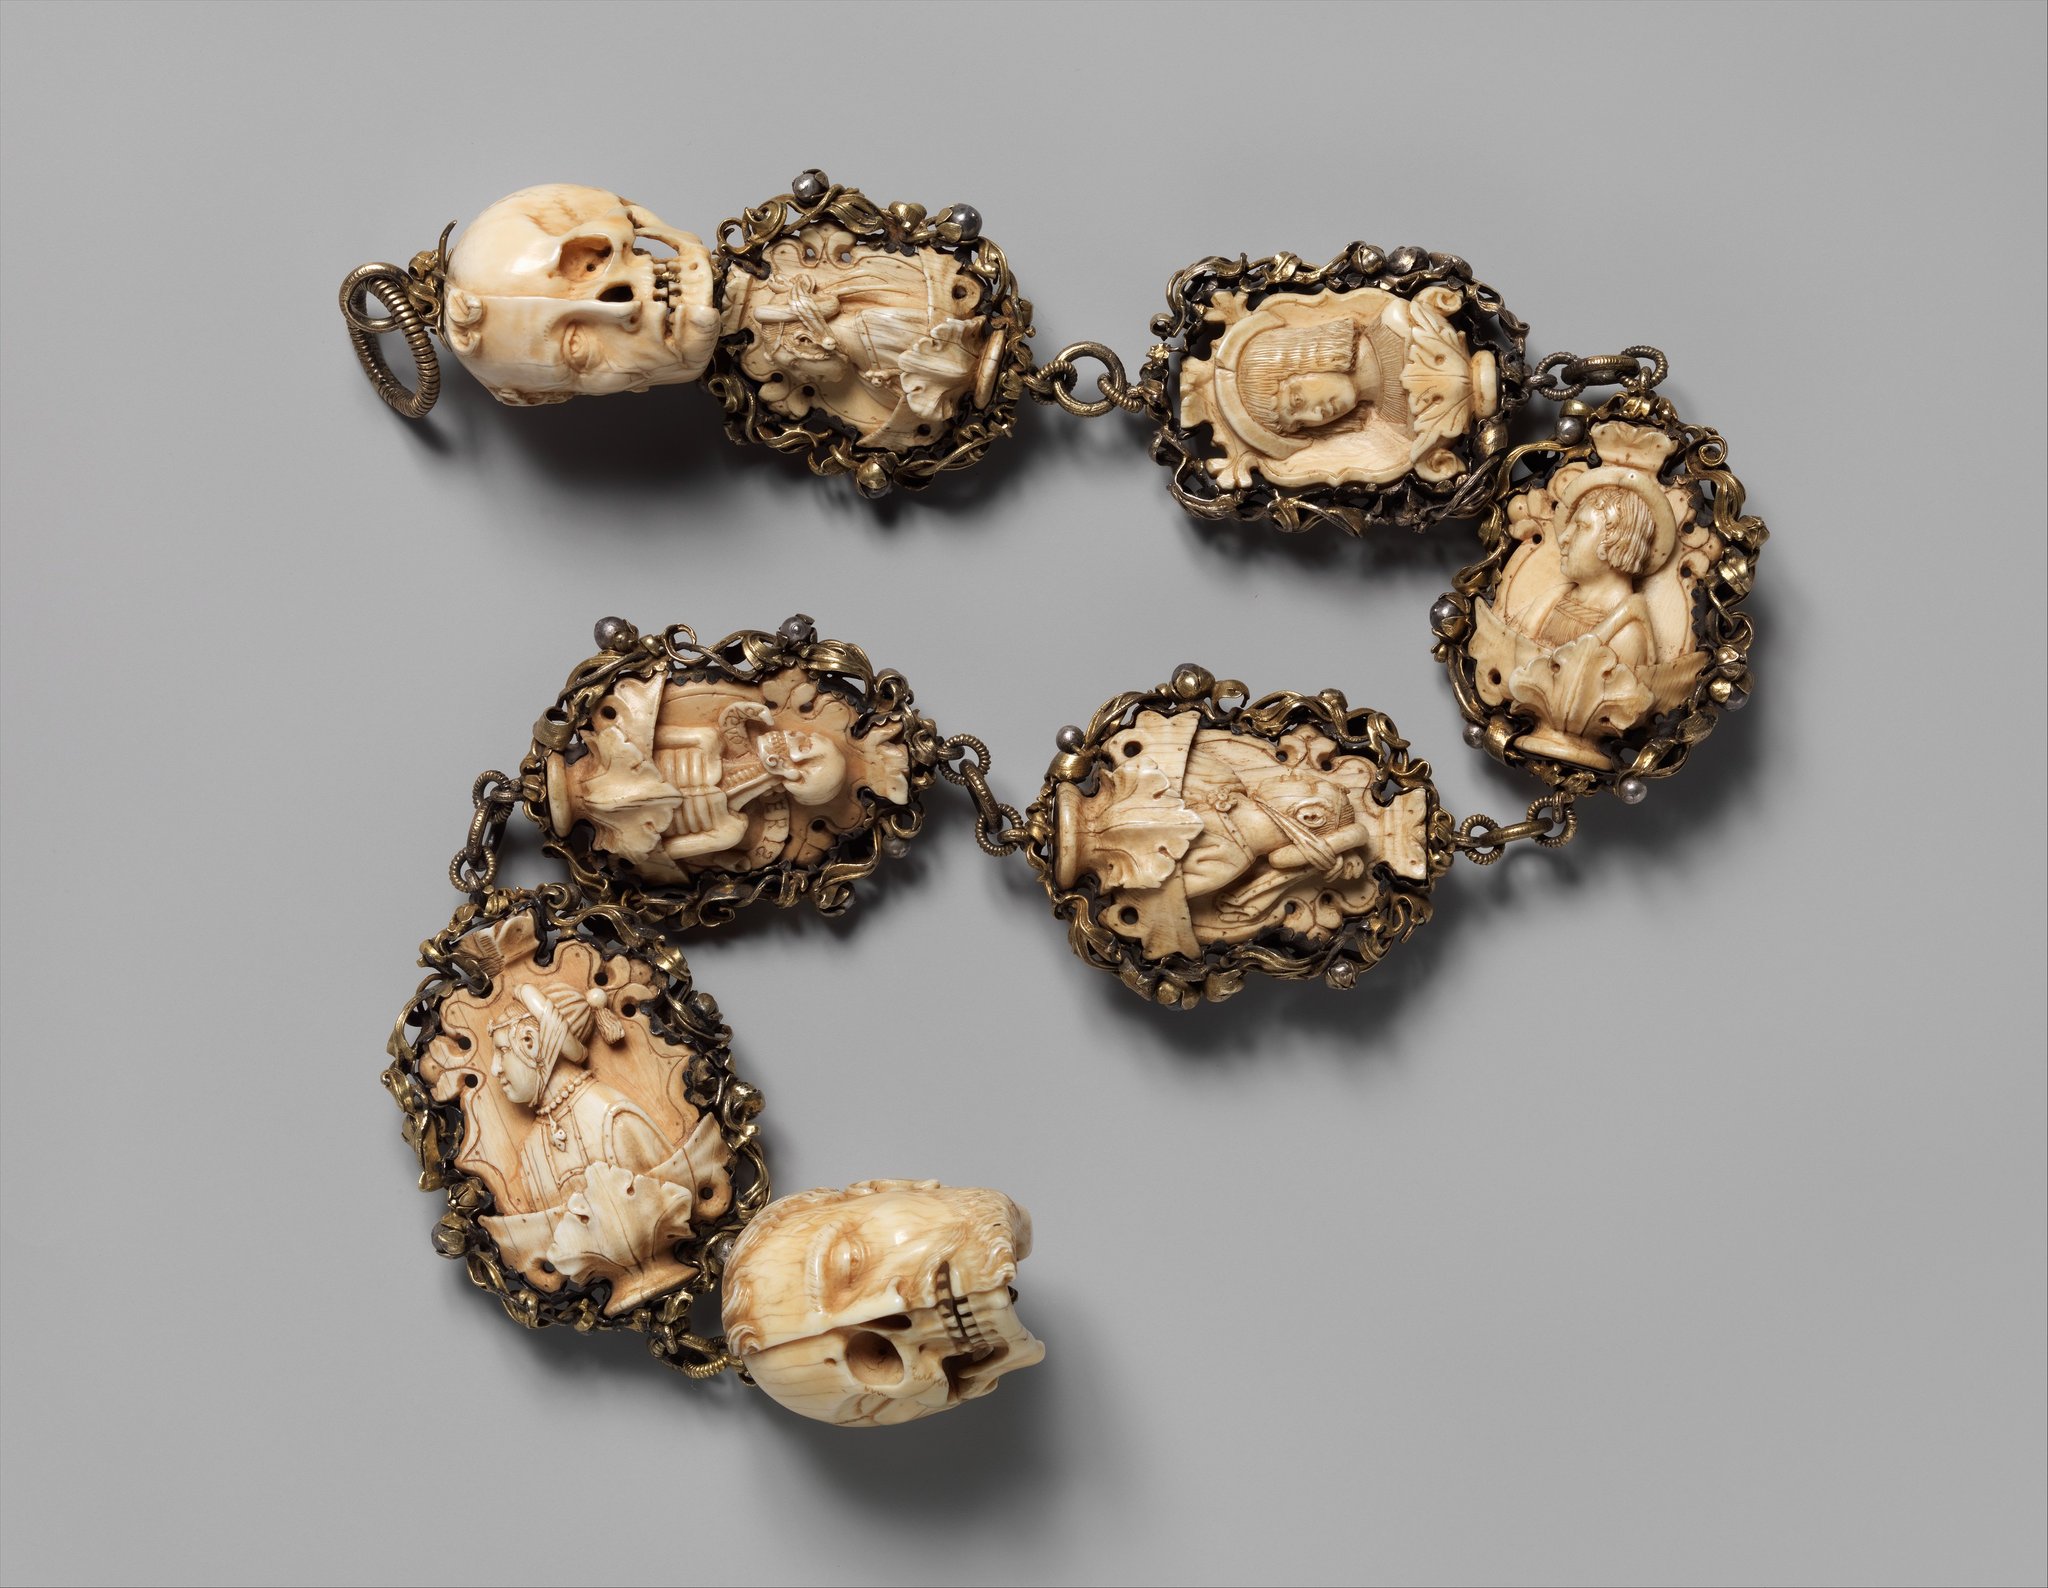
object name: rosary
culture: german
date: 1500-1525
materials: ivory, silver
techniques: gilding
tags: skeletons,skulls,men,women